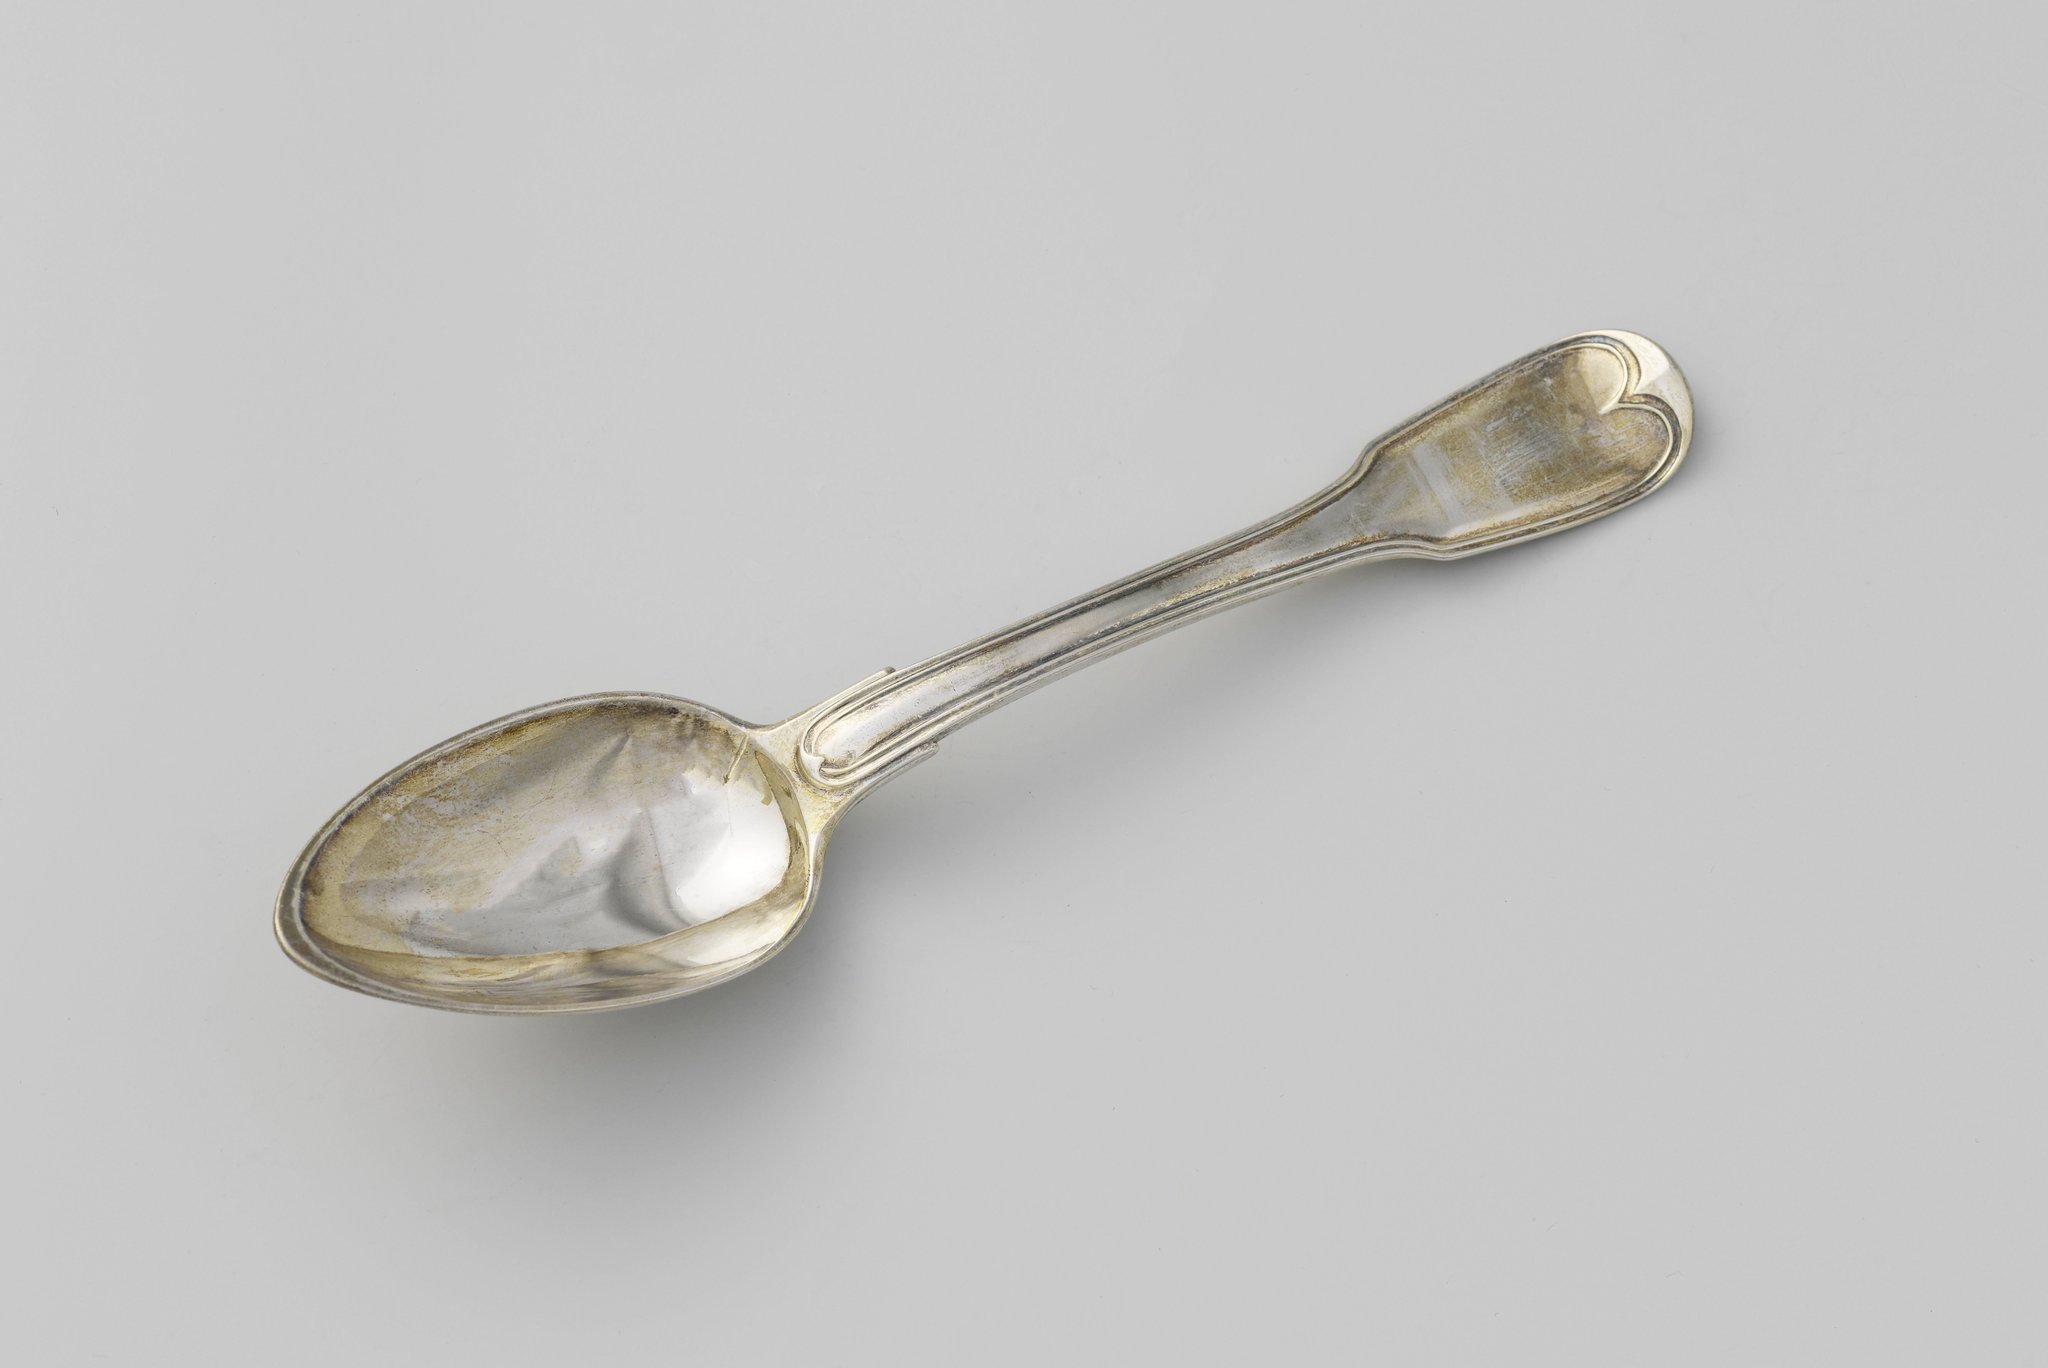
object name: spoon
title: Lepel met het helmteken Clifford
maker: hendrik helweg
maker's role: silversmith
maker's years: 1802-1858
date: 1832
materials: silver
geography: amsterdam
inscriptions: date letter: ‘X’, maker's mark, alloy mark, assay office mark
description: De eivormige bak van de lepel is aan zowel boven- als onderzijde door middel van enkel lof verbonden met de platte, gebogen steel, die zich verbreedt naar het spatelvormige uiteinde. Boven- en onderzijde van de steel worden omgeven door een dubbele filetrand, die bij het uiteinde ingezwenkt is. Op de onderzijde van de spatel is het helmteken Clifford gegraveerd.